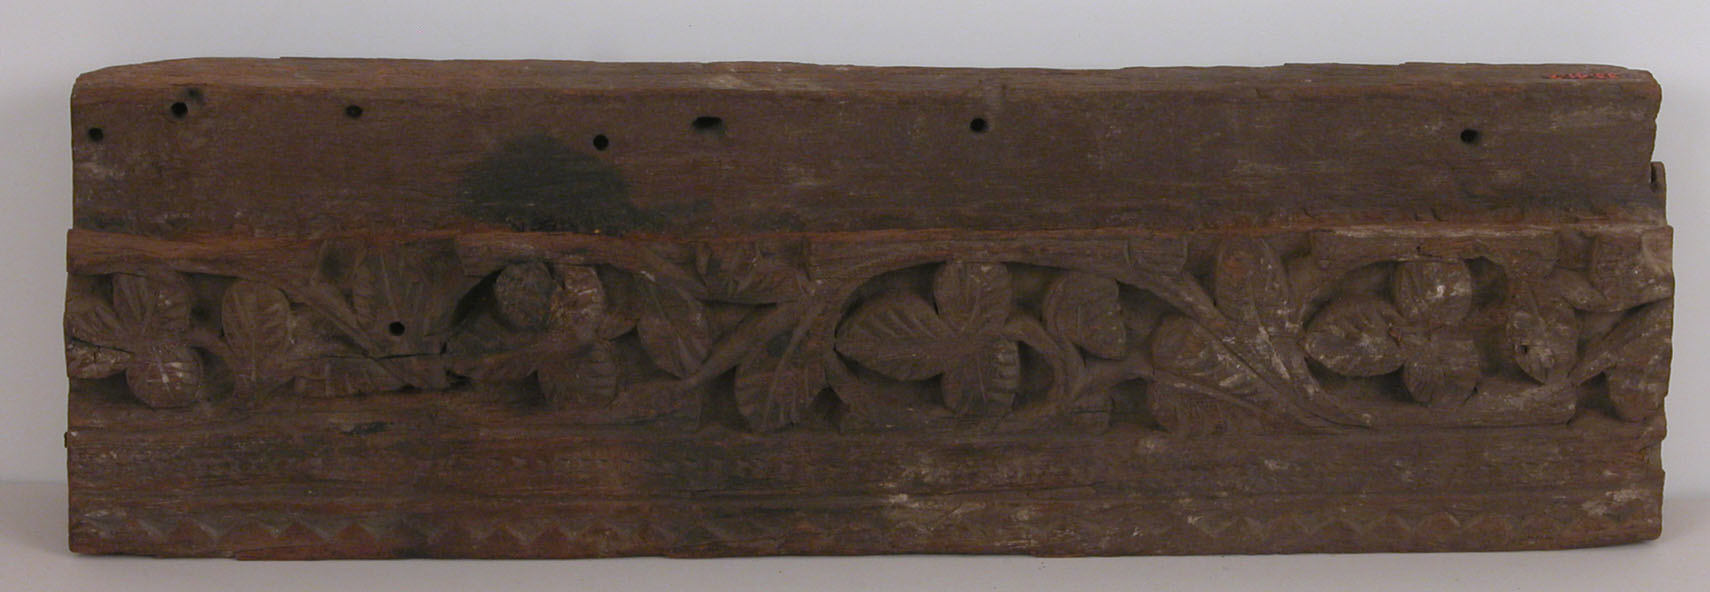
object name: panel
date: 701-900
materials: wood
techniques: carving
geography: iraq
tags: leaves